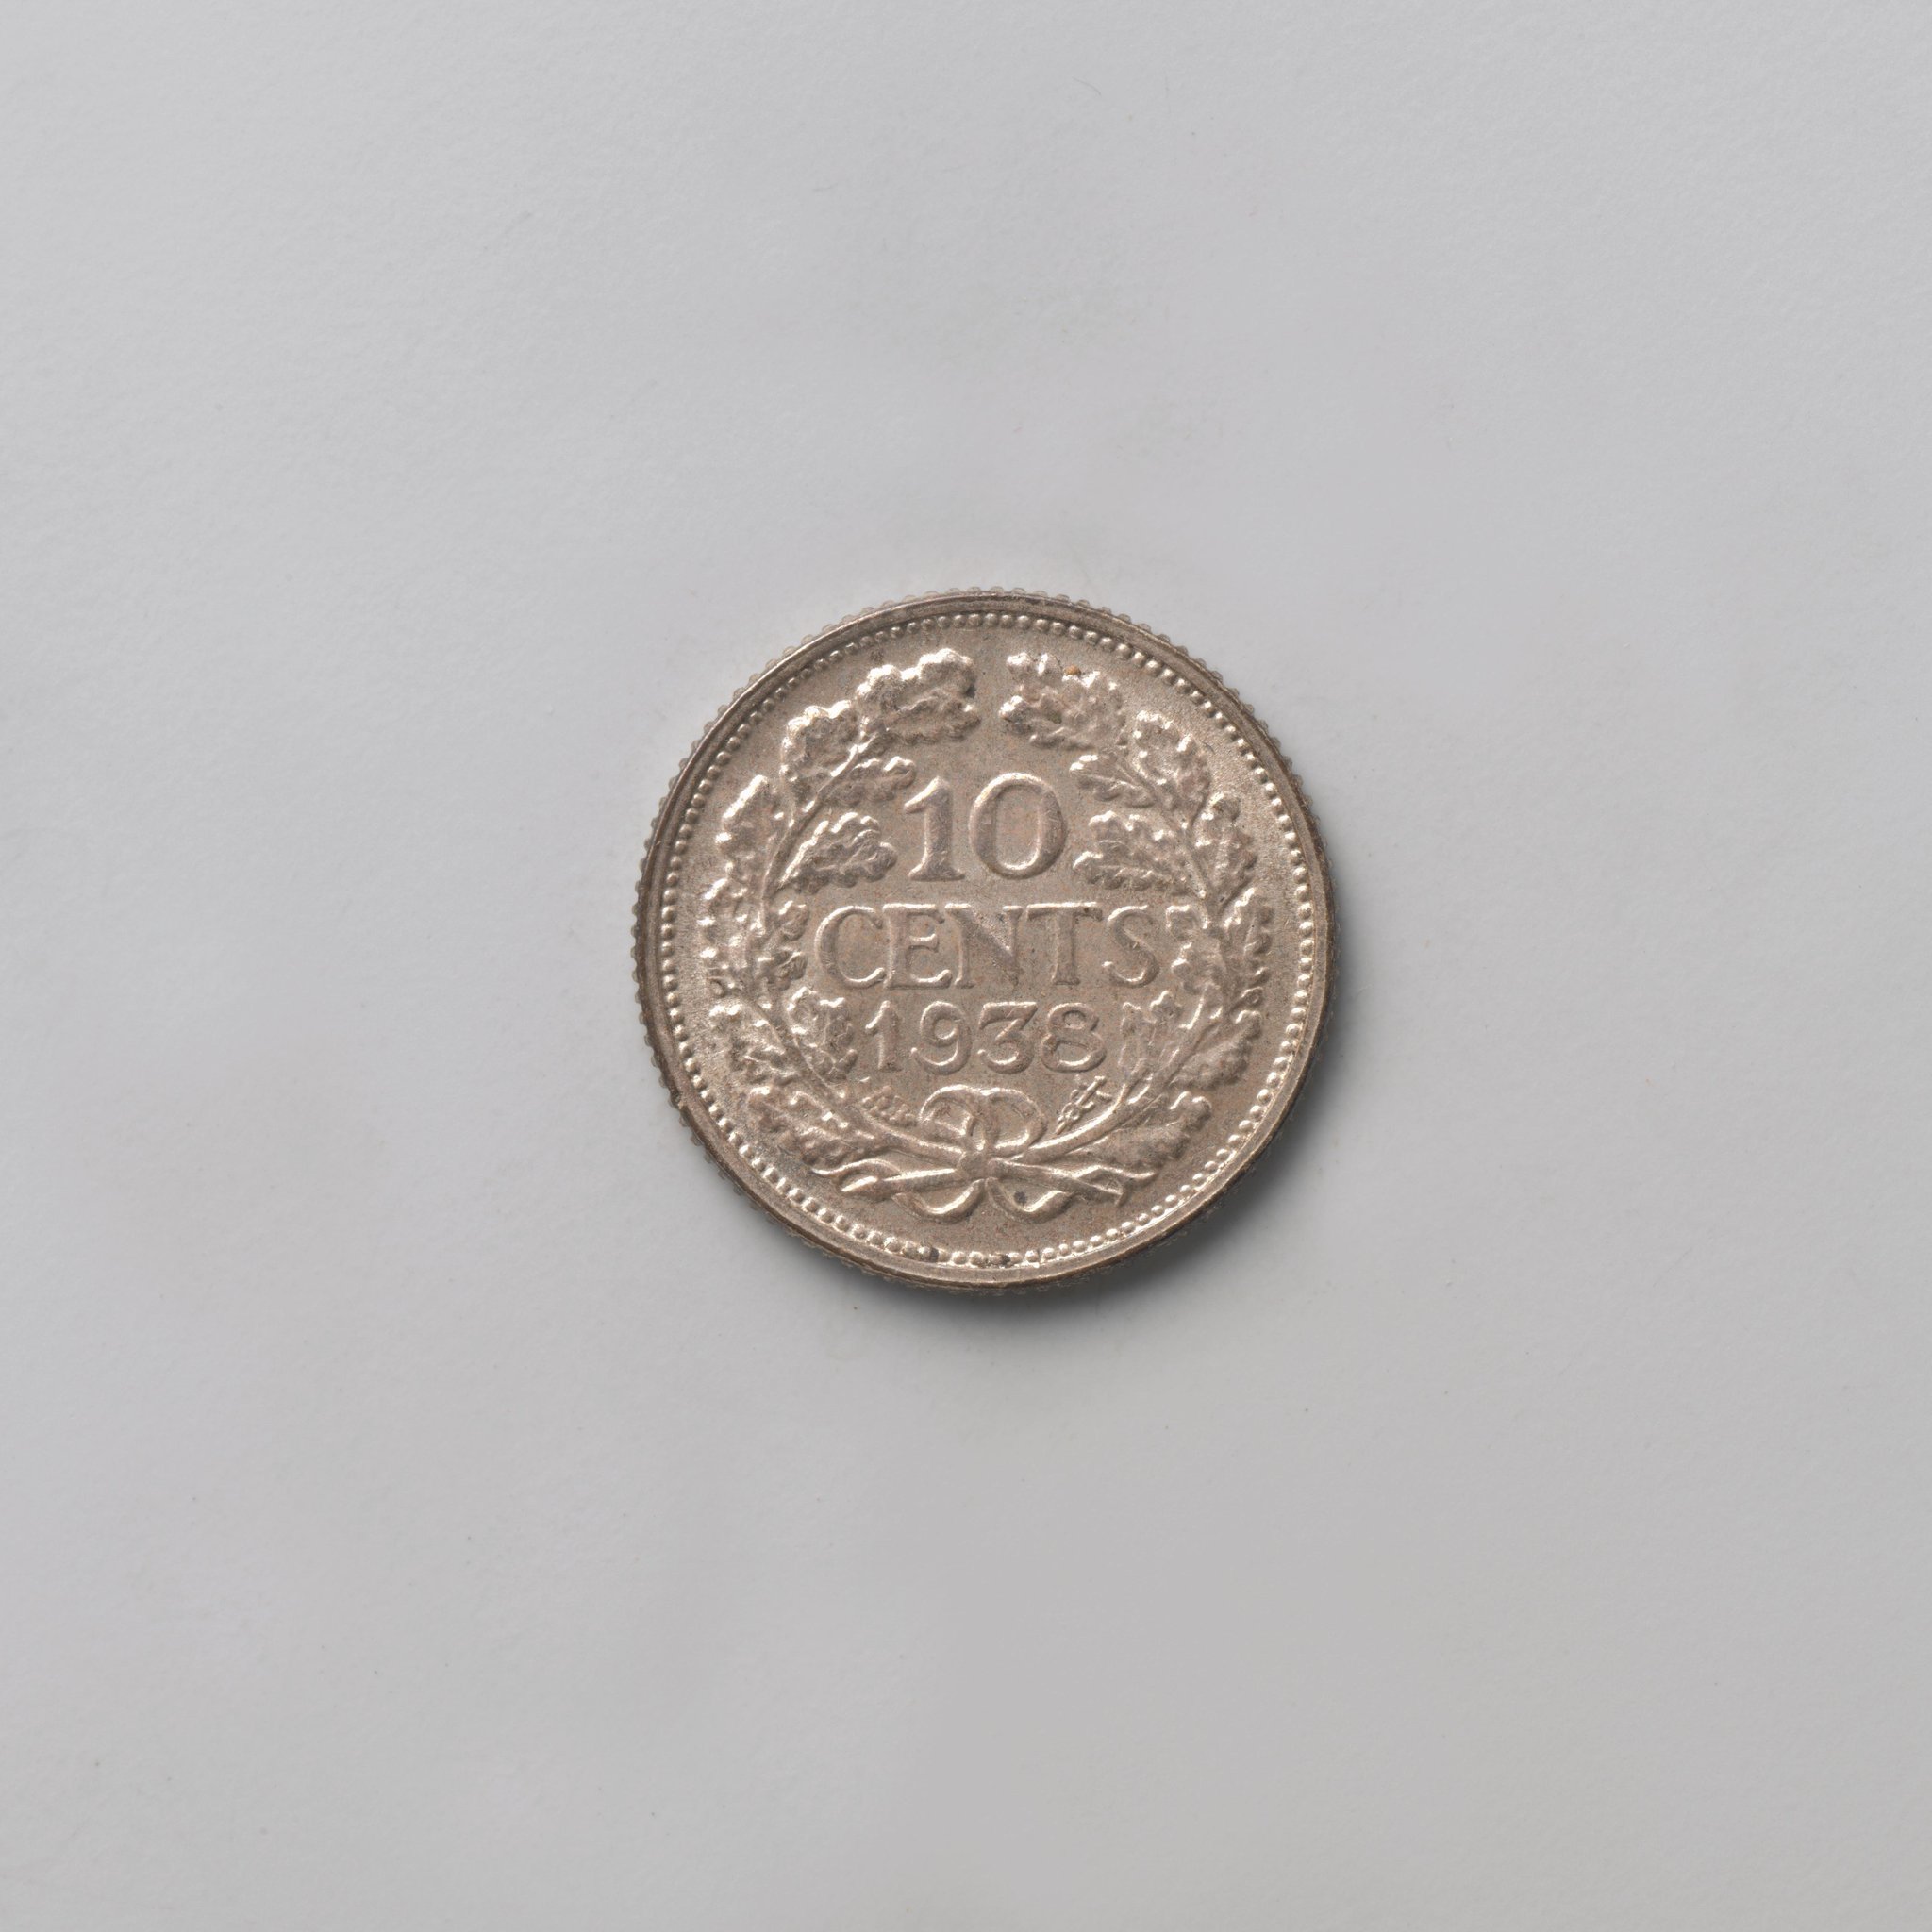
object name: coin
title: Nederlandse10 cent,1938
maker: wilhelmina of the netherlands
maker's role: print maker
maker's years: 1880-1962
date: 1938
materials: silver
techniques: striking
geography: utrecht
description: Zilveren munt. Voorzijde: hoofd naar links. Keerzijde: binnen twee samengebonden eiketakken waarde-aanduiding 10 cents en jaartal. Kartelrand.